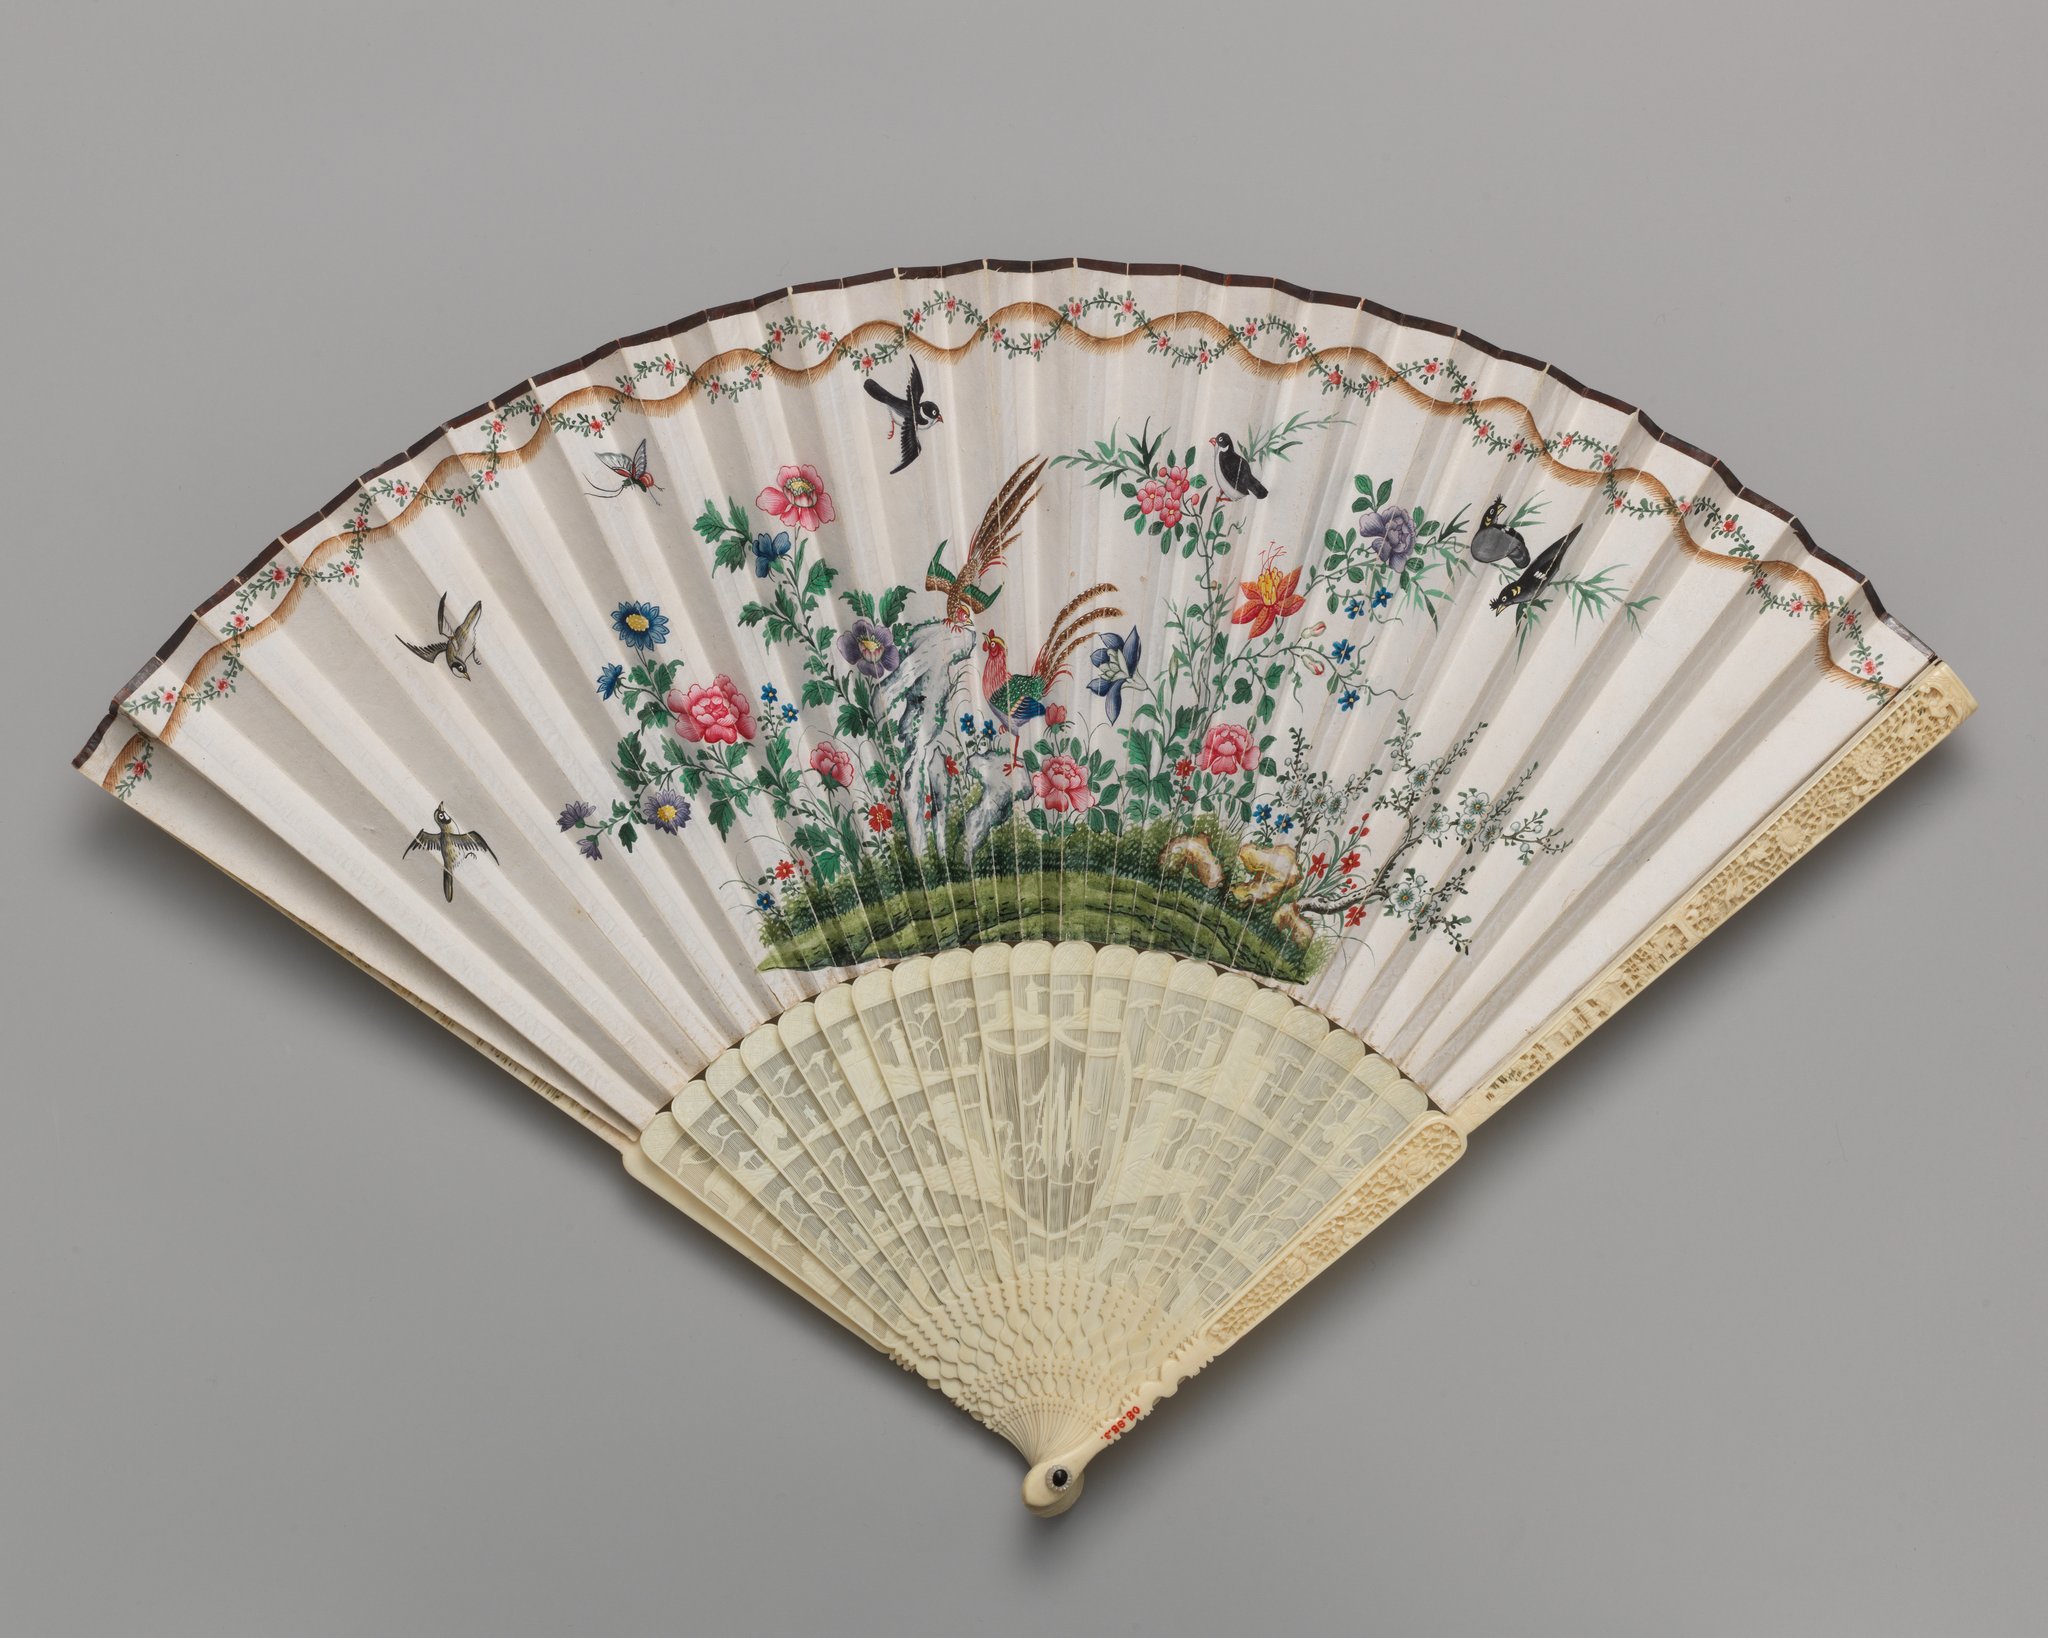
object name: fan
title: Folding Fan with Representation of Birds and Flowers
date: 1767-1833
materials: ivory, paper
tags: birds,flowers